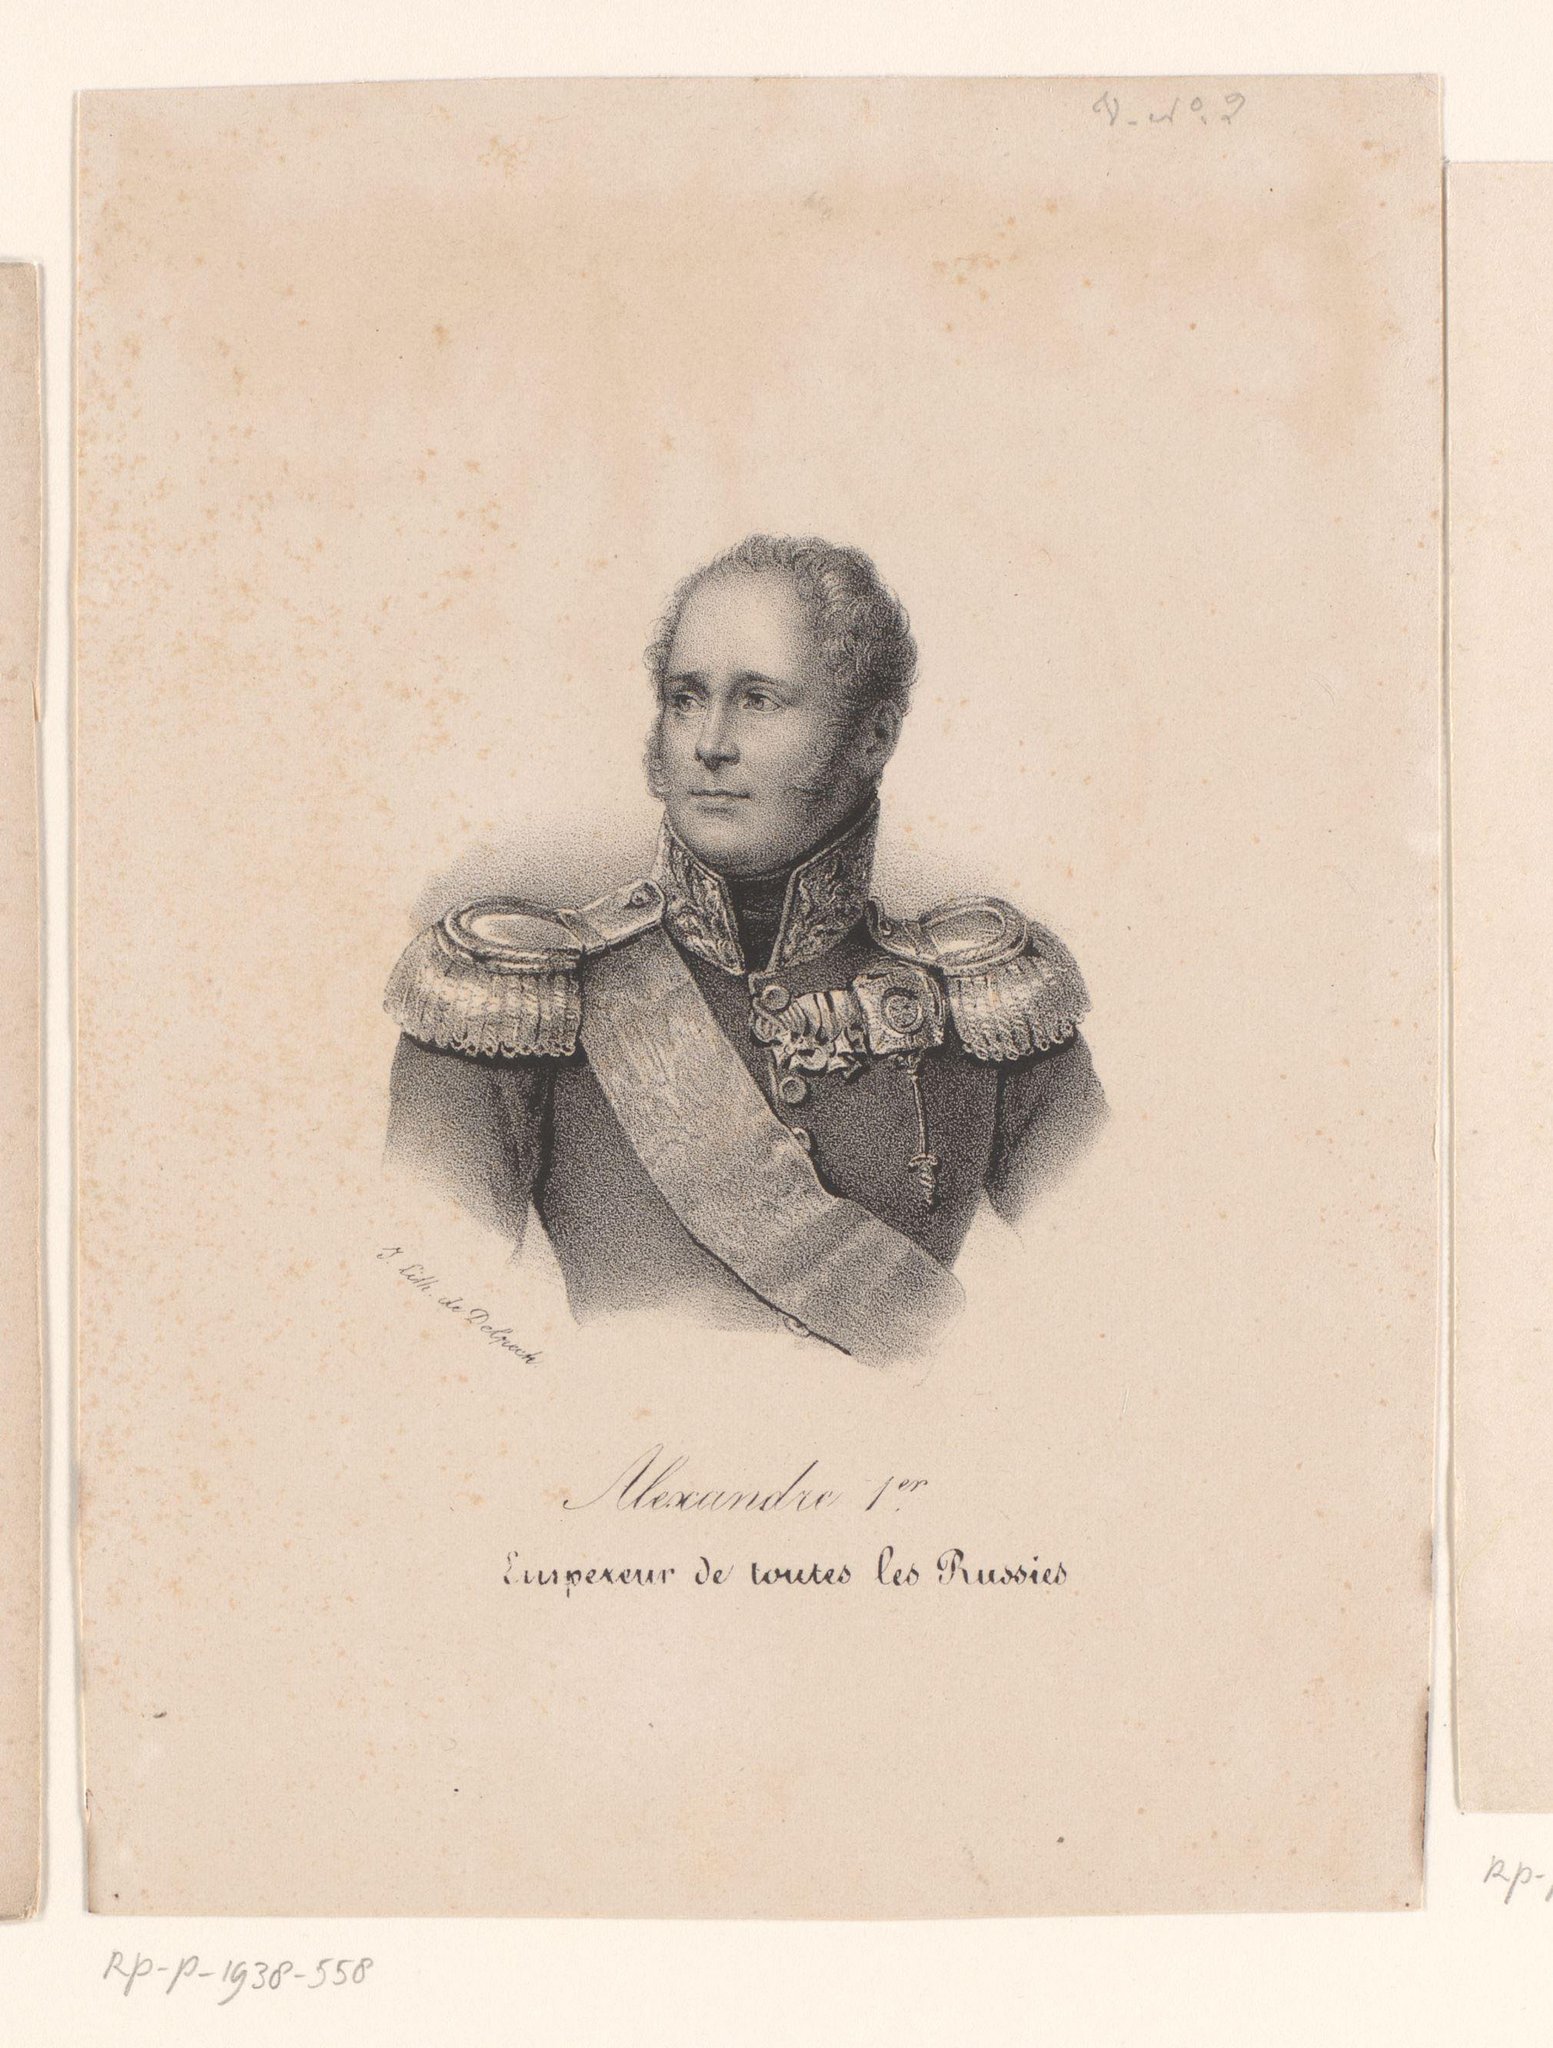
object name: print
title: Portret van tsaar Alexander I van Rusland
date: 1818-1842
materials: paper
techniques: lithograph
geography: paris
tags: alexander i (tsaar van rusland), historical persons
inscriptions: collector's mark: Lugt 2228a